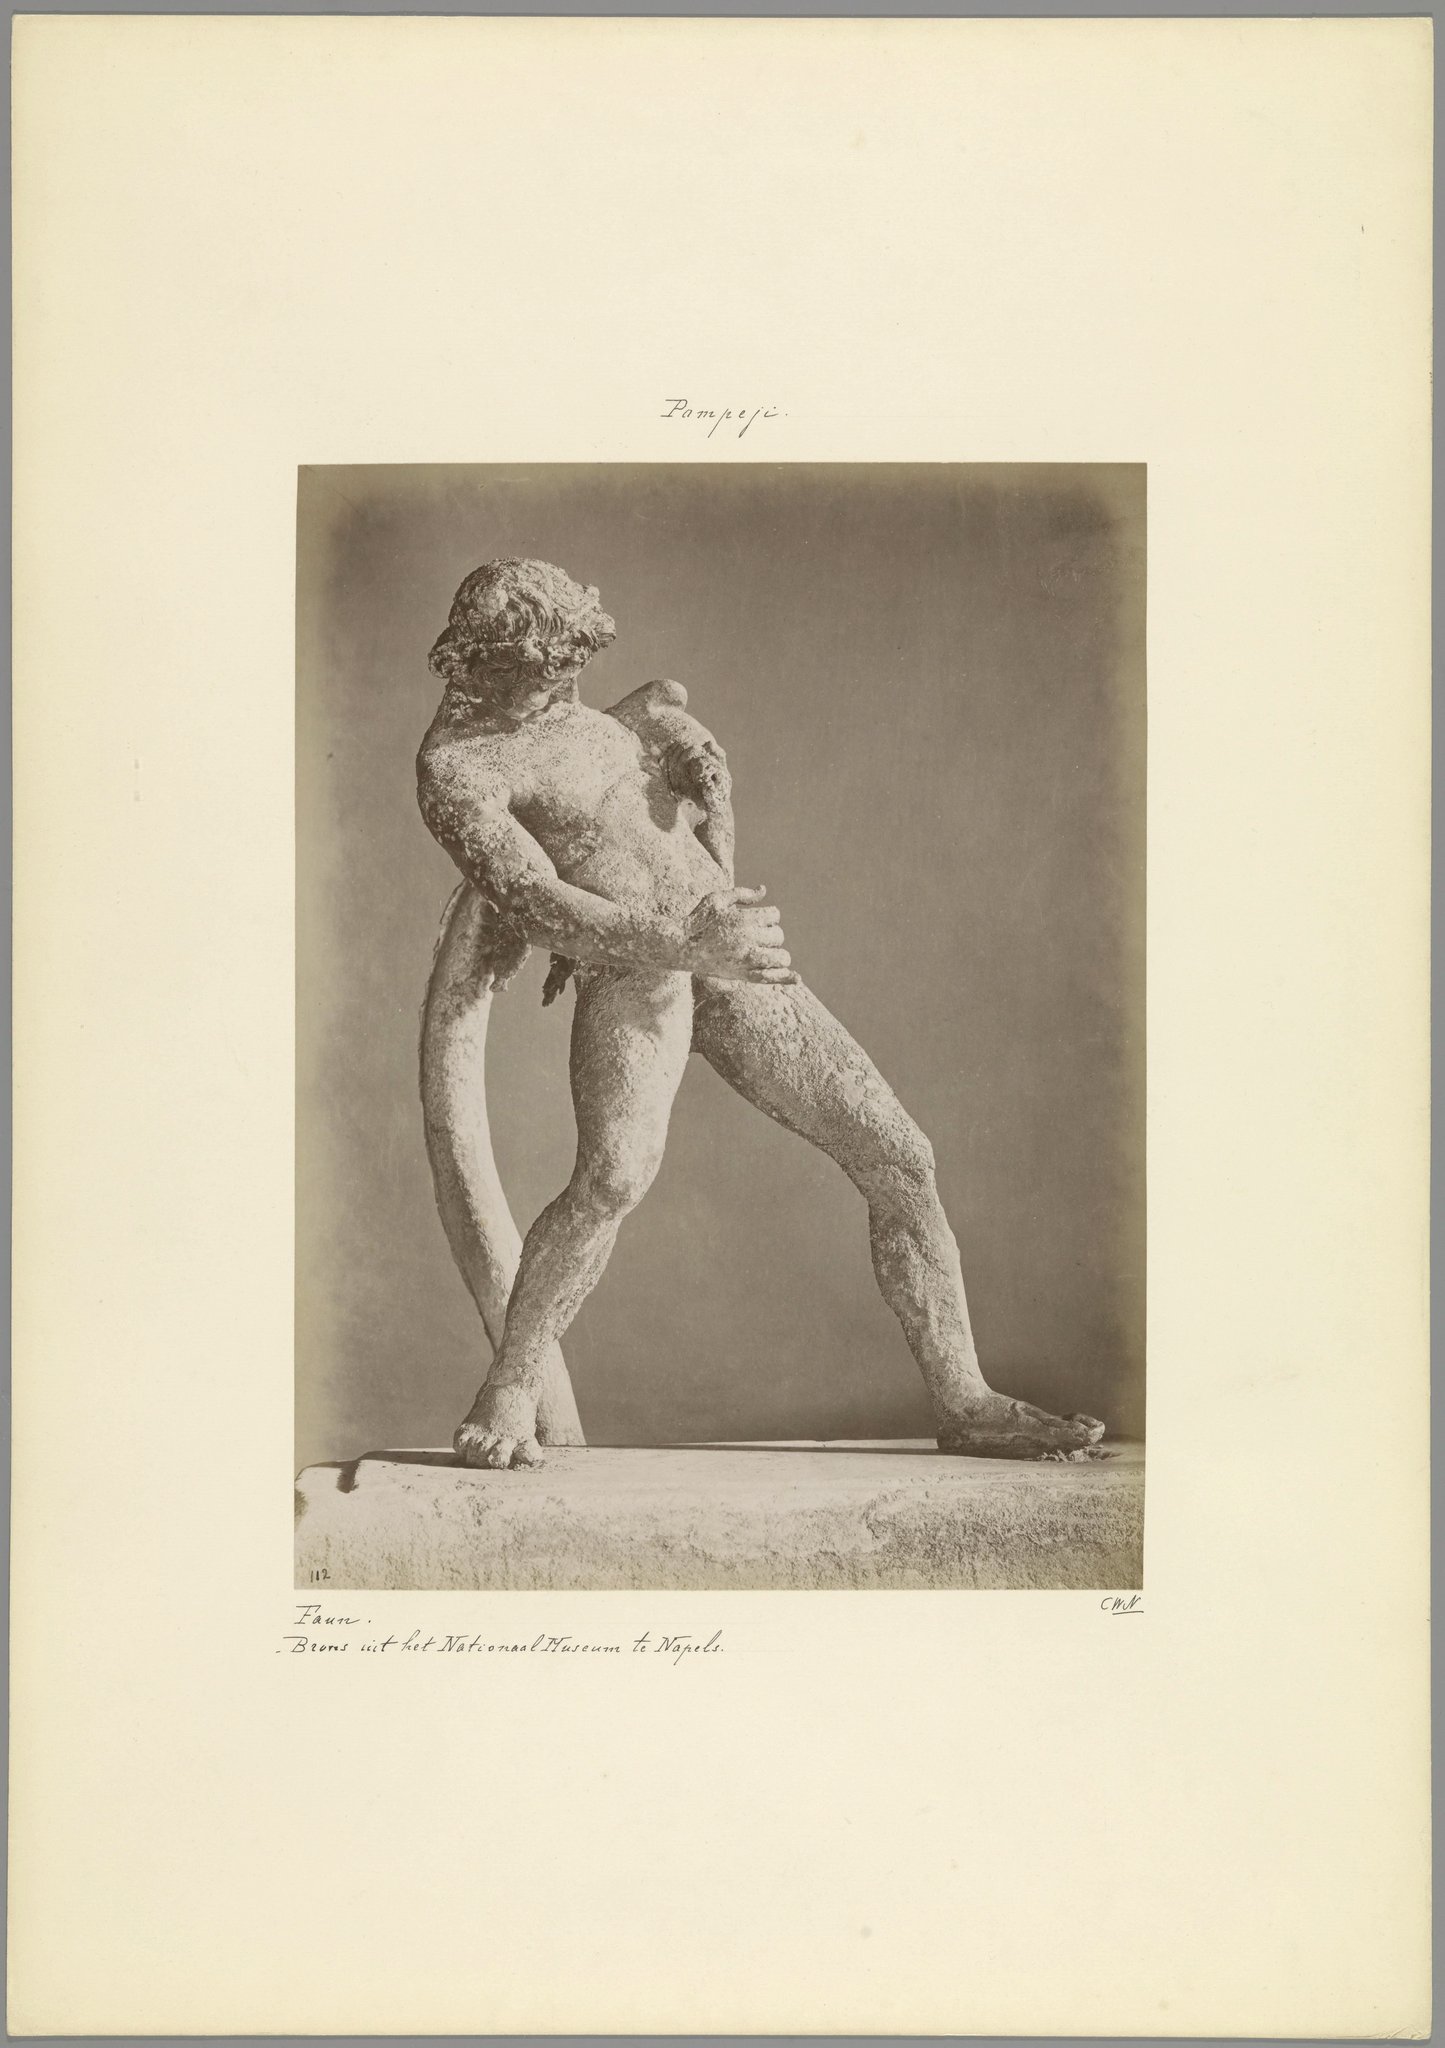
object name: photograph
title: Bronzen beeld van een faun met een wijnzak, afkomstig uit Pompeï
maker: Anonymous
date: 1875-1900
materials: cardboard, photographic support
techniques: albumen print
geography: naples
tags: wine ~ alcoholic drinks, satyr(s) (in general), sculpture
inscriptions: inscription: ‘CWN.’, collector's mark: ‘KUNSTNIJVERHEIDSCHOOL QUELLINUS AMSTERDAM FRANS HALSSTRAAT 14.’, collector's mark: ‘INSTITUUT VOOR KUNST-NIJVERHEIDSONDERWIJS GABRIËL METSUSTRAAT No. 16. AMSTERDAM’, number: ‘112’, inscription: ‘Pompeji. Faun. Brons uit het Nationaal Museum te Napels’